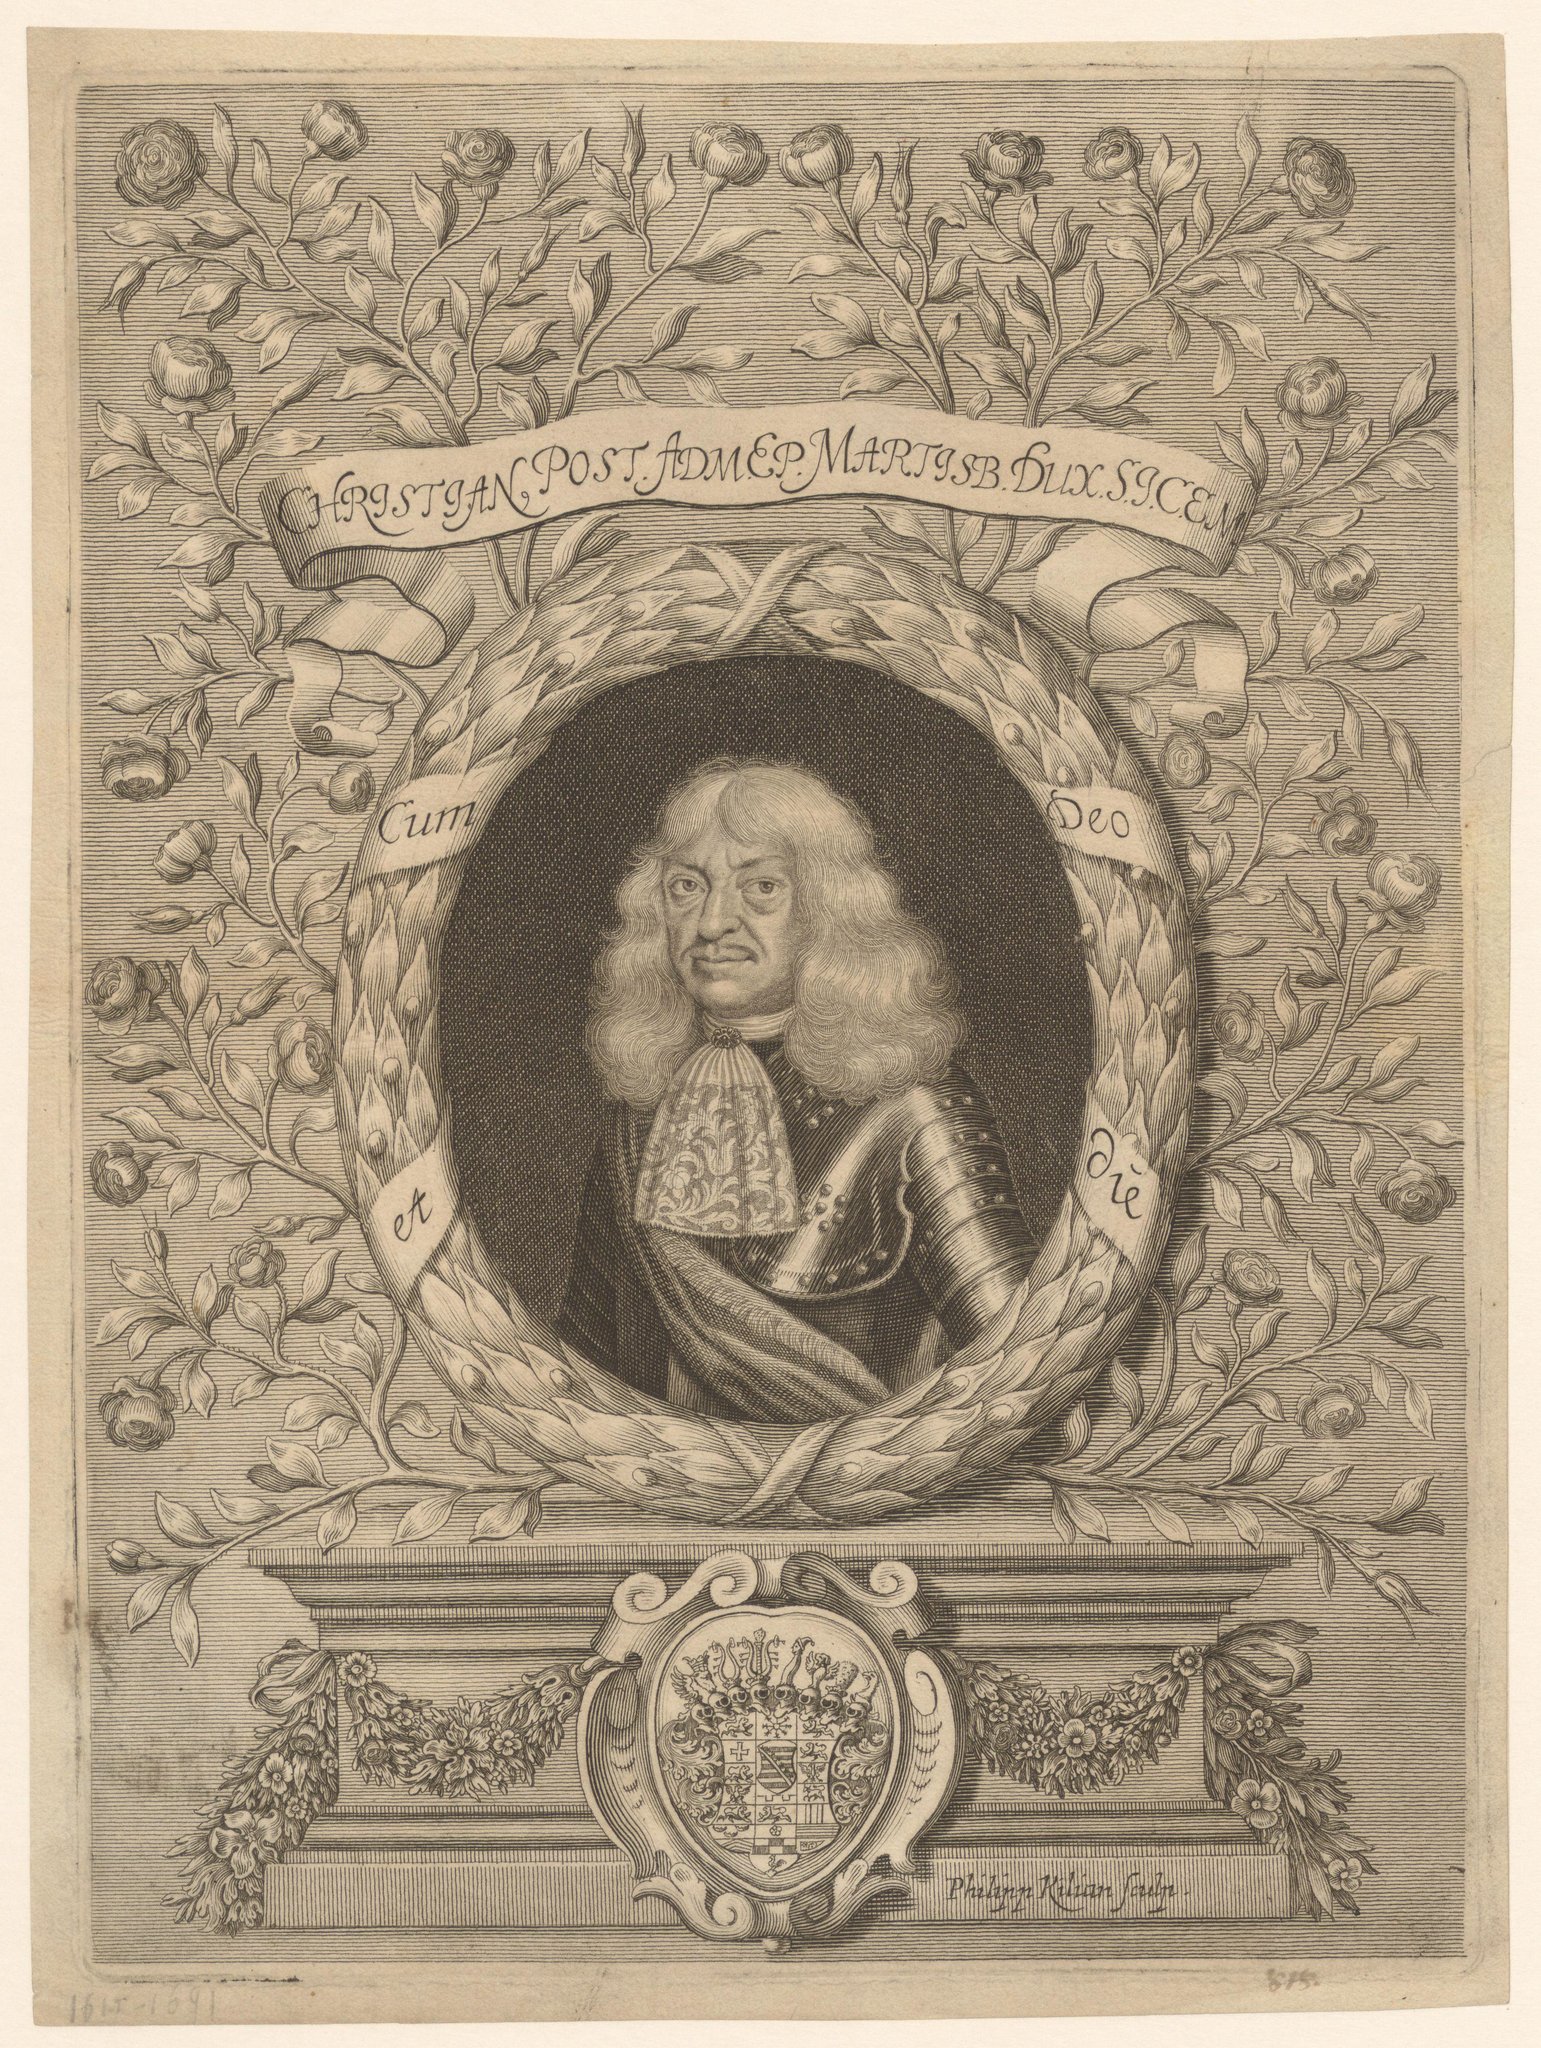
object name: print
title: Portret van Christian van Saksen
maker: philipp kilian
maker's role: print maker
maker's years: 1628-1693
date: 1663-1693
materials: paper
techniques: engraving, etching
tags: historical persons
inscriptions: collector's mark: Lugt 2228